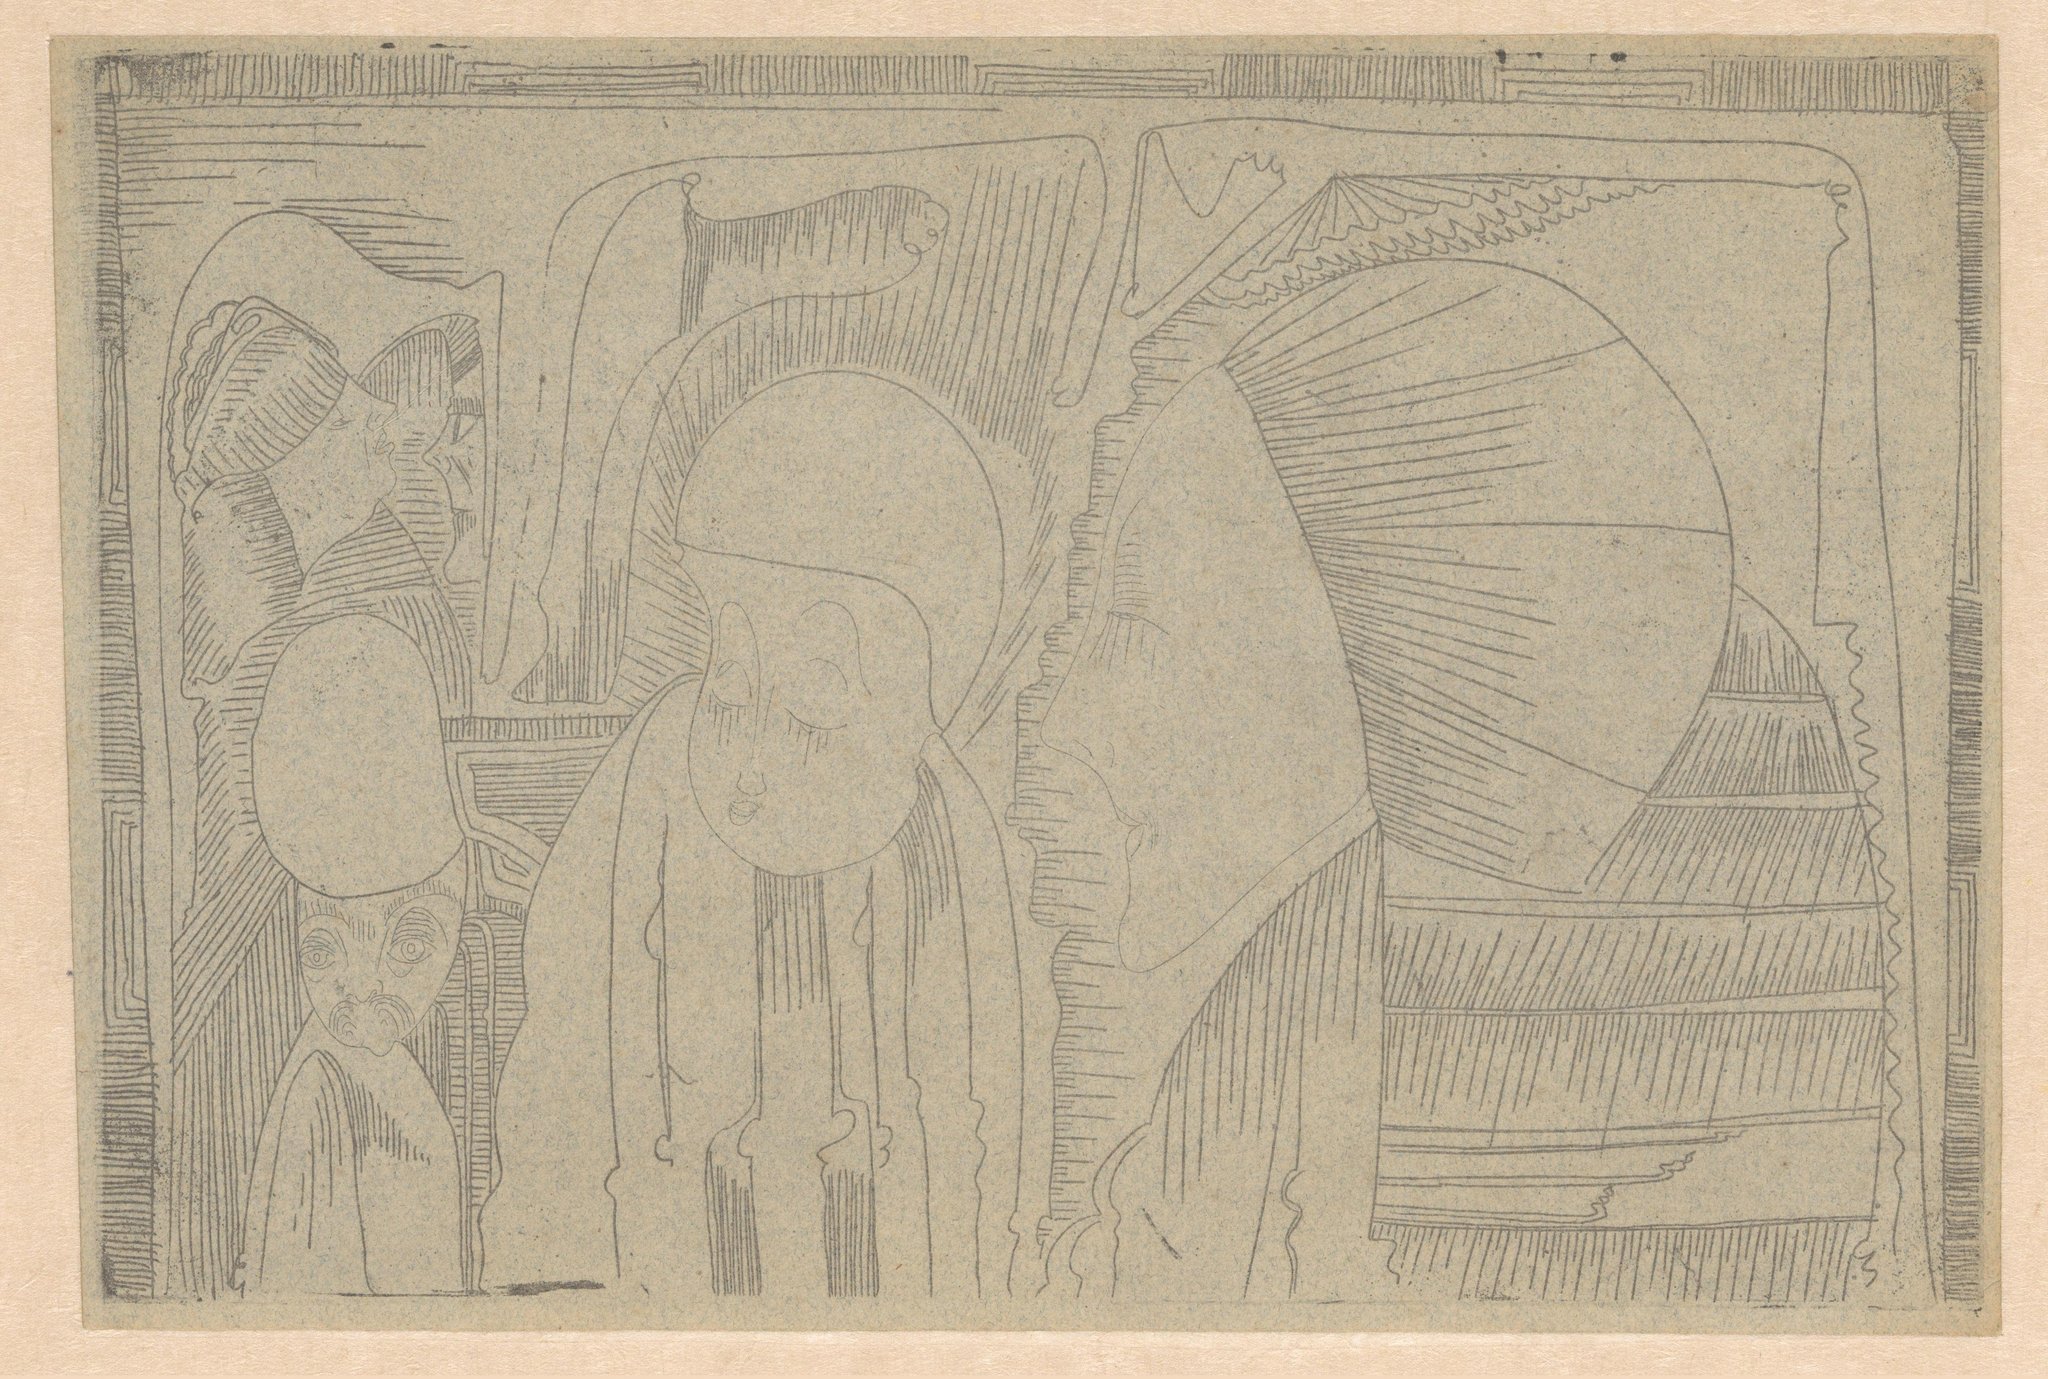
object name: print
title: Fantasie: diverse figuren, links een profiel naar rechts met geloken ogen en pruimmondje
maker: samuel jessurun de mesquita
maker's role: draughtsman, print maker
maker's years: 1868-1944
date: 1924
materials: paper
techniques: printmaking, etching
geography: netherlands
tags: caricatures (human types), eyes closed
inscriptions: collector's mark: Lugt 2228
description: Vijf koppen: op de voorgrond een kop in profiel, naar links, met neergeslagen ogen; in het midden een figuur van voren gezien, eveneens met de ogen dicht. Links een kop van een man met wijd open ogen. Op de achtergrond twee koppen tegenover elkaar. (Tegendruk van inv.nr. 1995-401)